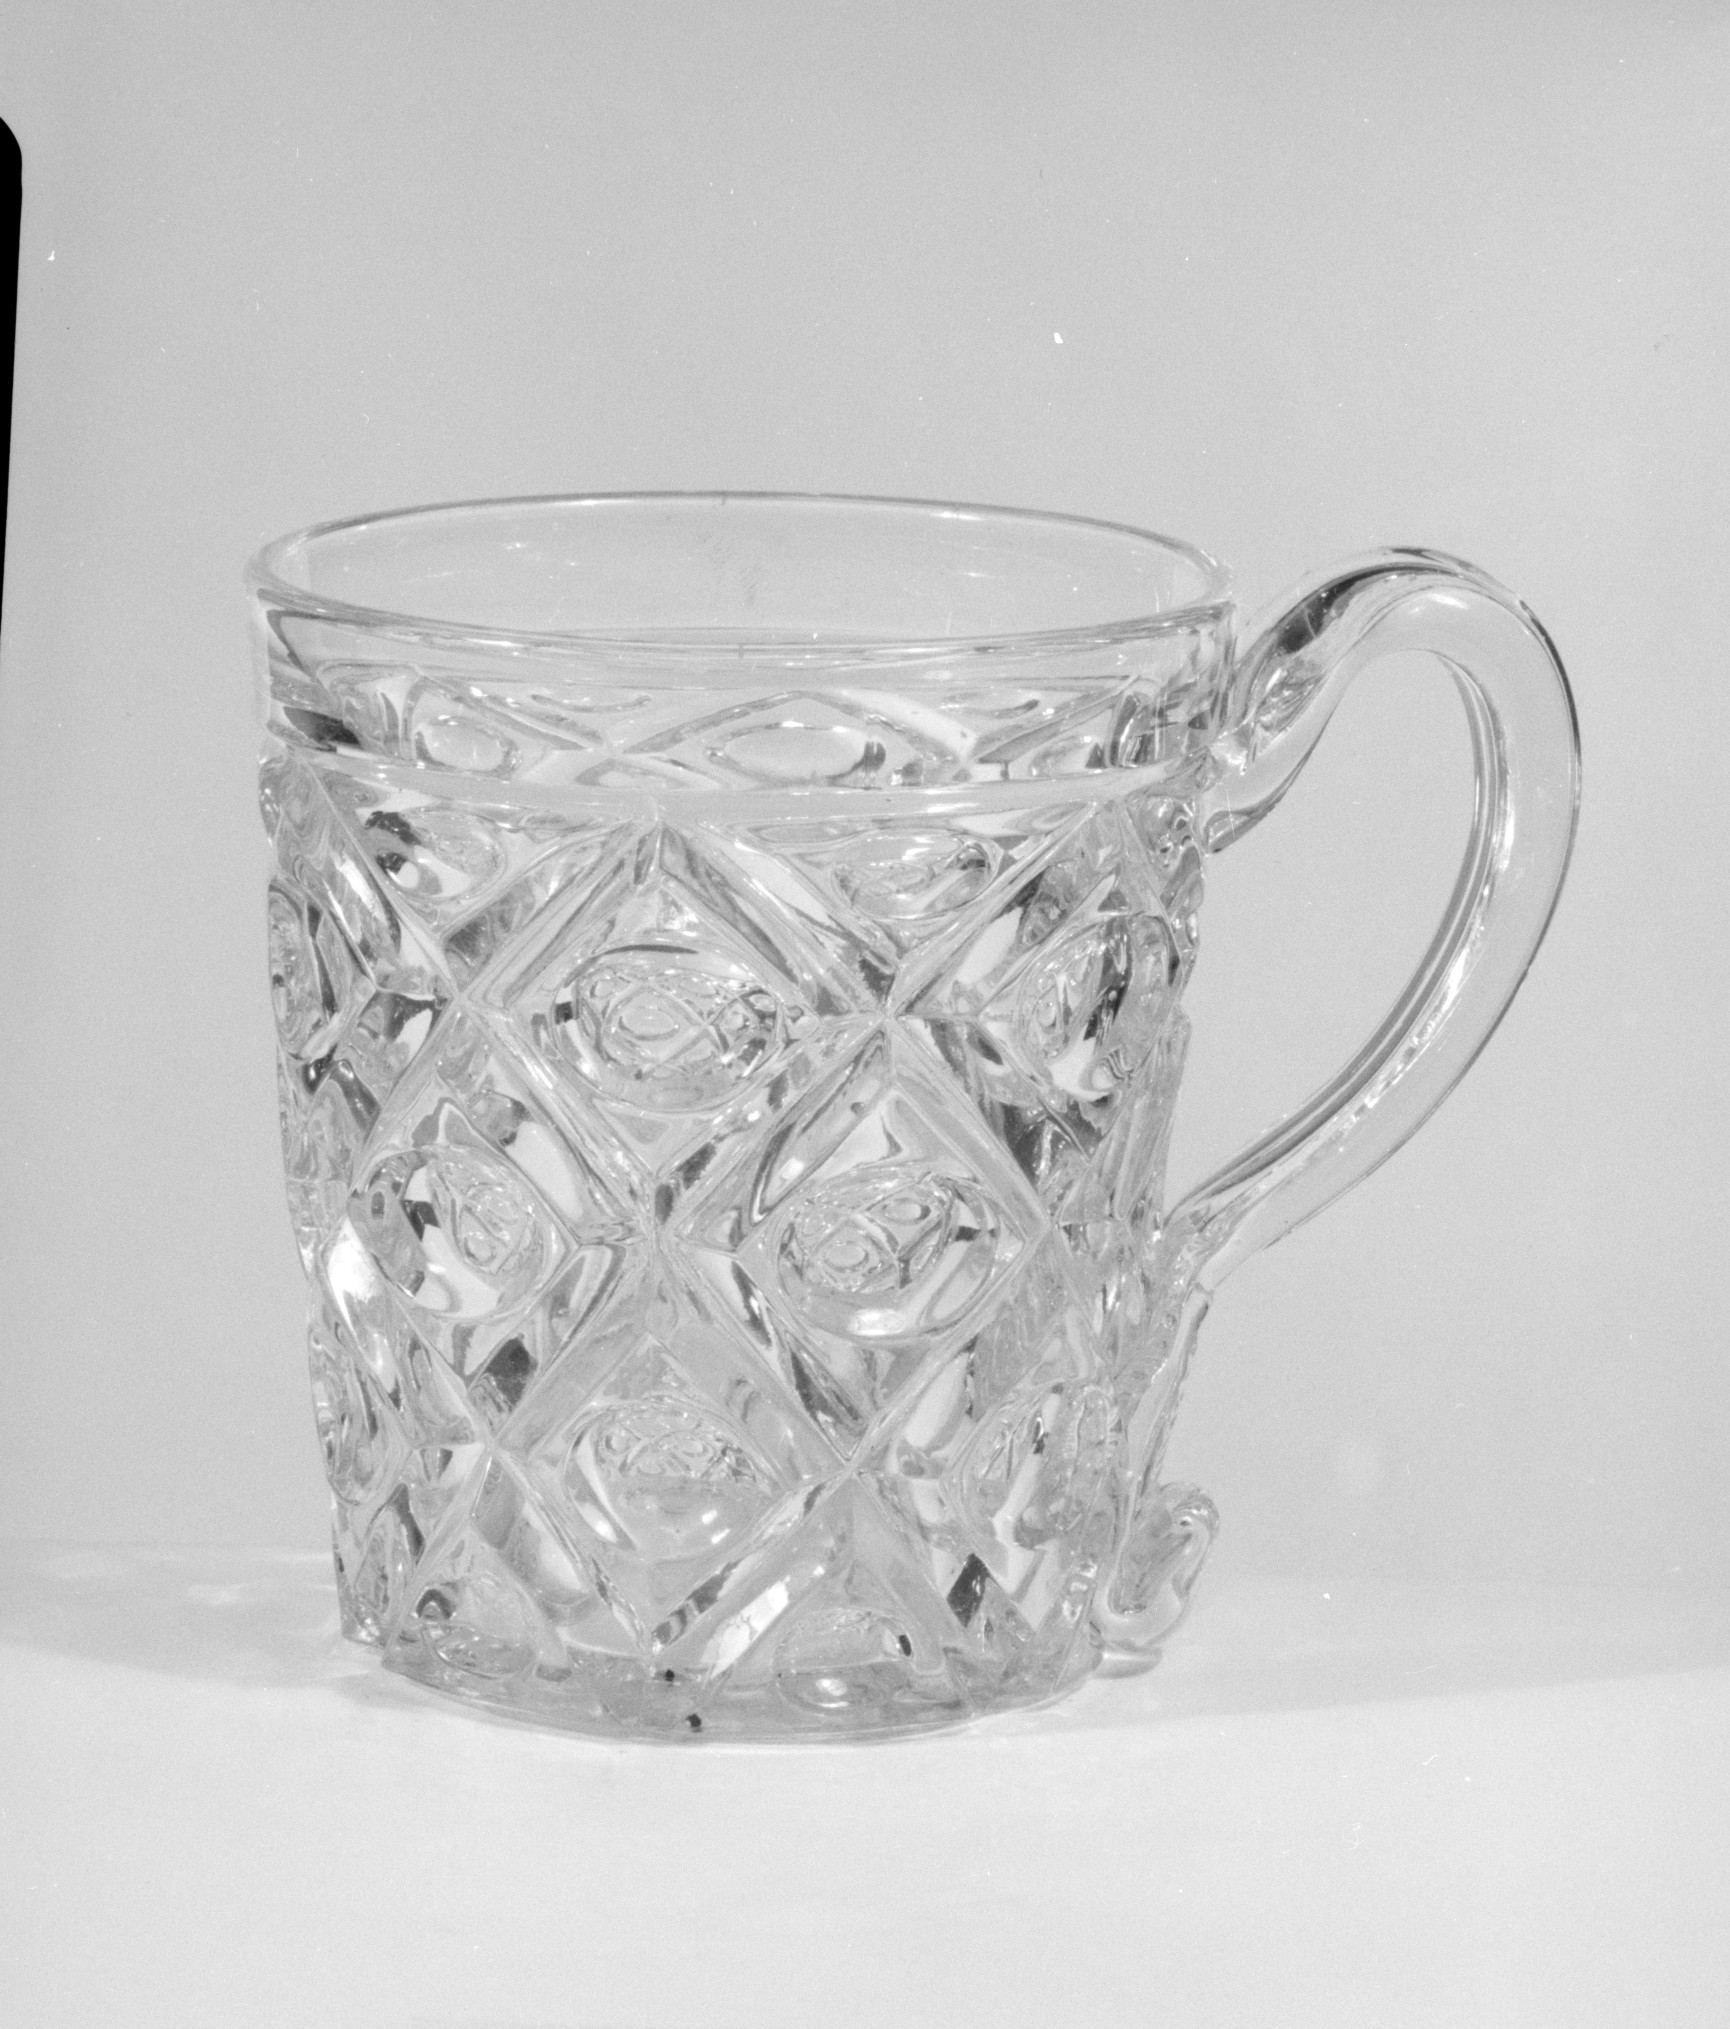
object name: mug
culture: american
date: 1850-1870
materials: diamond, glass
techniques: pressed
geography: united states